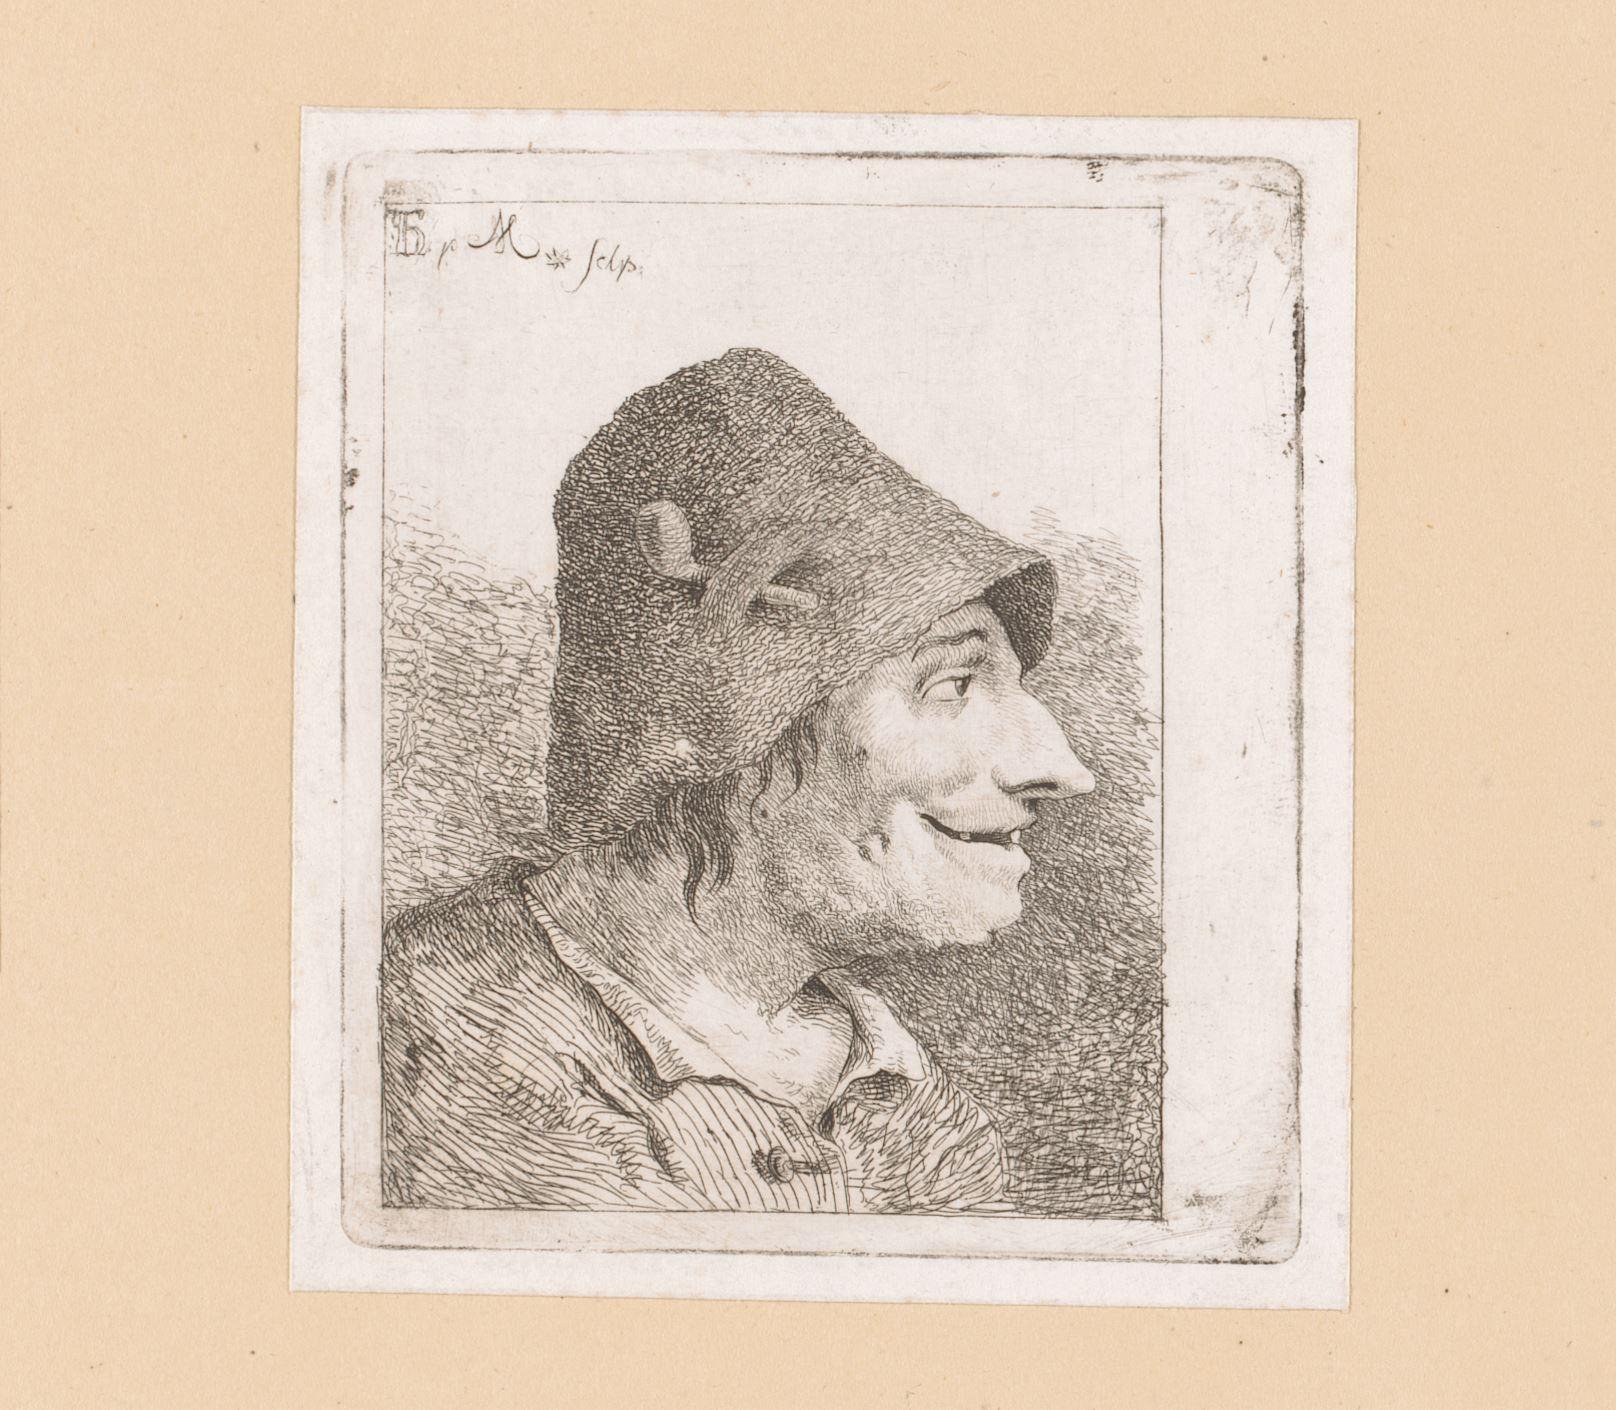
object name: print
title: Kop van een onbekende man, lachend met pijp in zijn hoed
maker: johann friedrich morgenstern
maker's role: print maker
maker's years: 1777-1844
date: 1787-1844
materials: paper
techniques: etching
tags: adult man, laughing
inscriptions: collector's mark: Lugt 2228